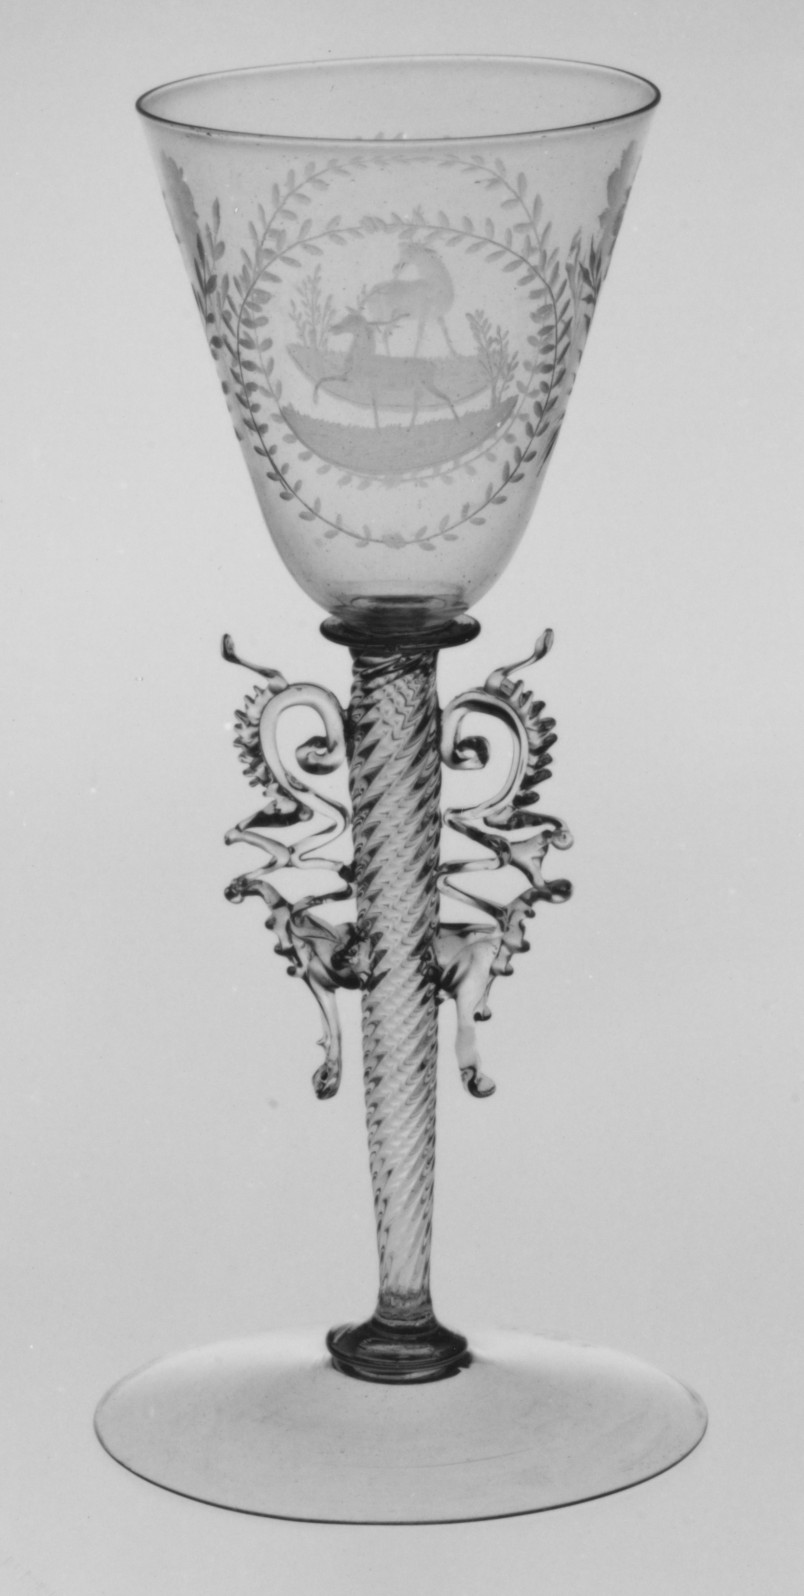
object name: wineglass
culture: italian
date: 1601-1700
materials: glass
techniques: glassblowing, engraving, molding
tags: deer